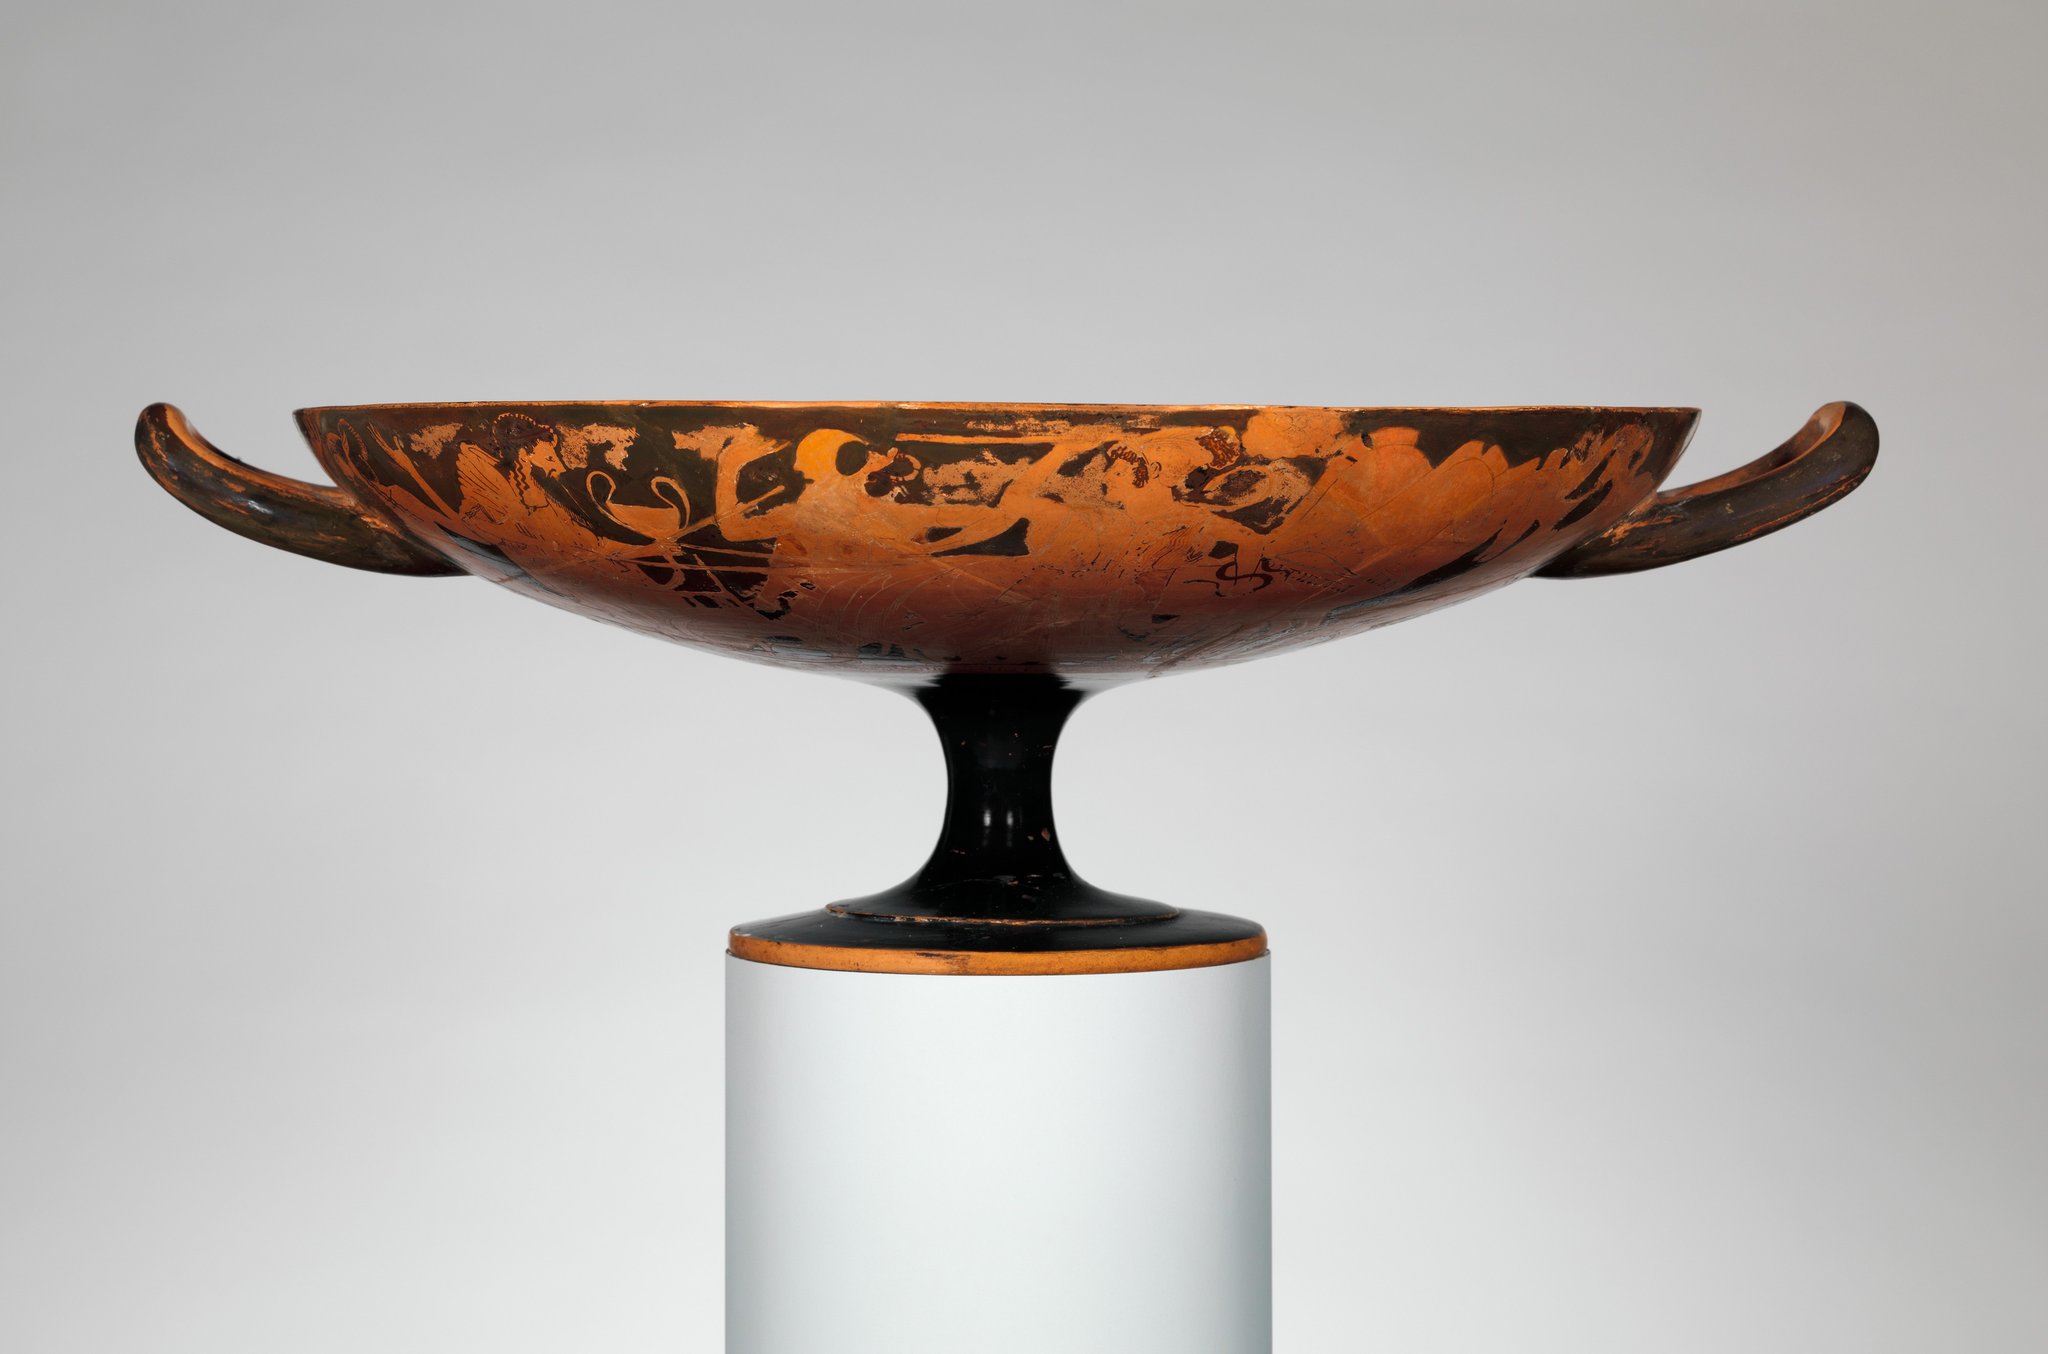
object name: kylix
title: Terracotta kylix (drinking cup)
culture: greek, attic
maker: magnoncourt painter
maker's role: artist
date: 490-480 BCE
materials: terracotta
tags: dionysus,ariadne,maenads,satyrs